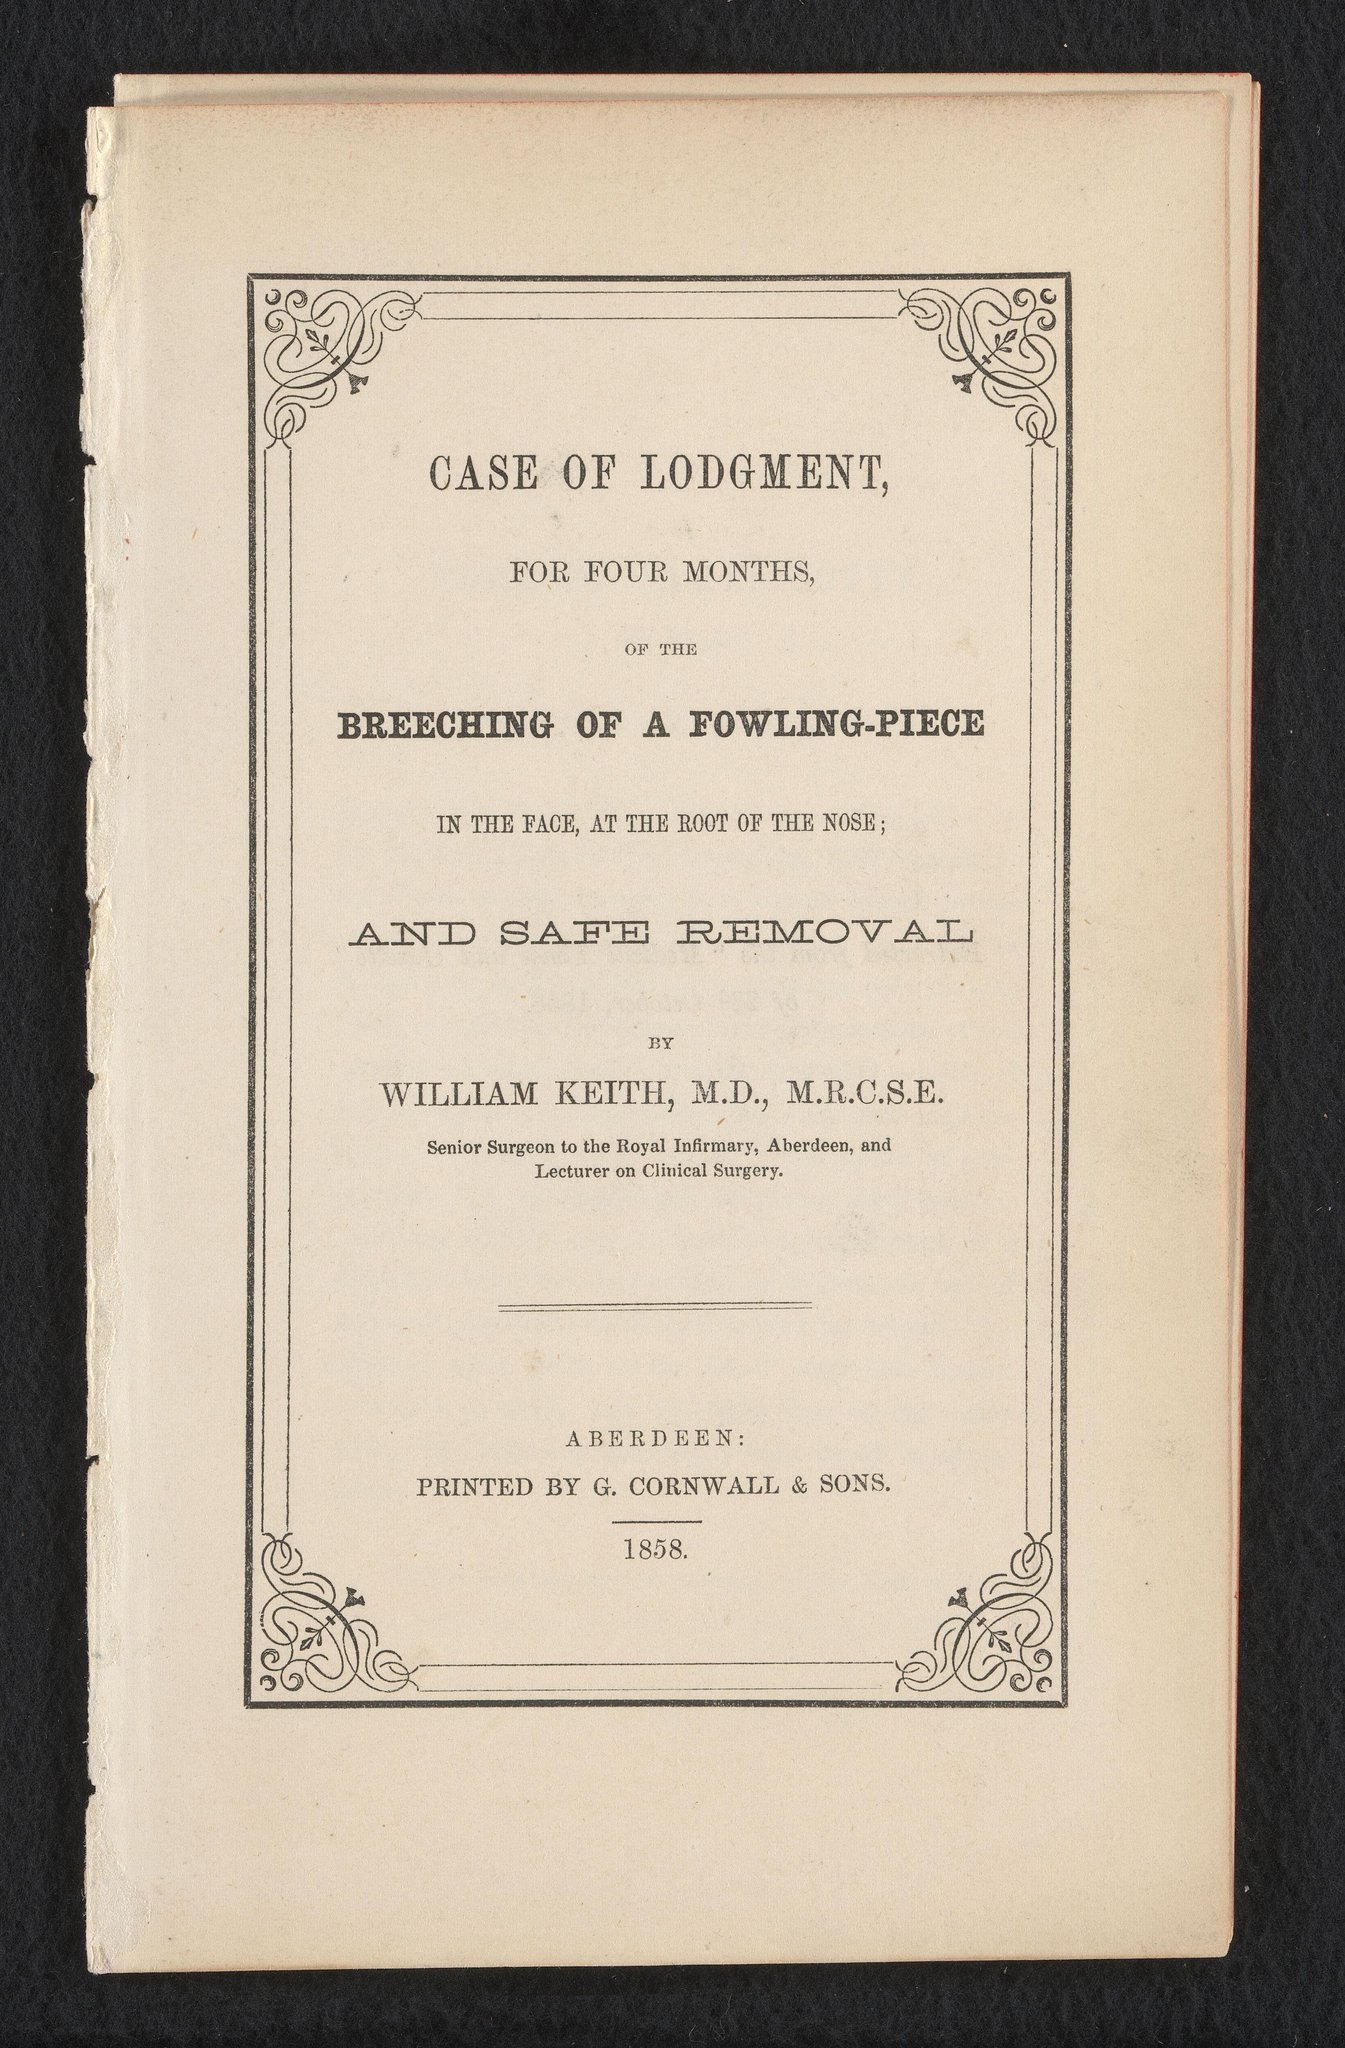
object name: book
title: Case of Lodgment, for four Months, of the Breeching of a Fowling-Piece (...)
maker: william keith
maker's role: dokter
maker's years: 1802-1871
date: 1858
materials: paper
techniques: albumen print, letterpress printing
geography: aberdeen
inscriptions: inscription: ‘£ 80’, date: ‘OKT 2005’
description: Extracted from the "Medical Times and Gazette" of 23d October, 1858.